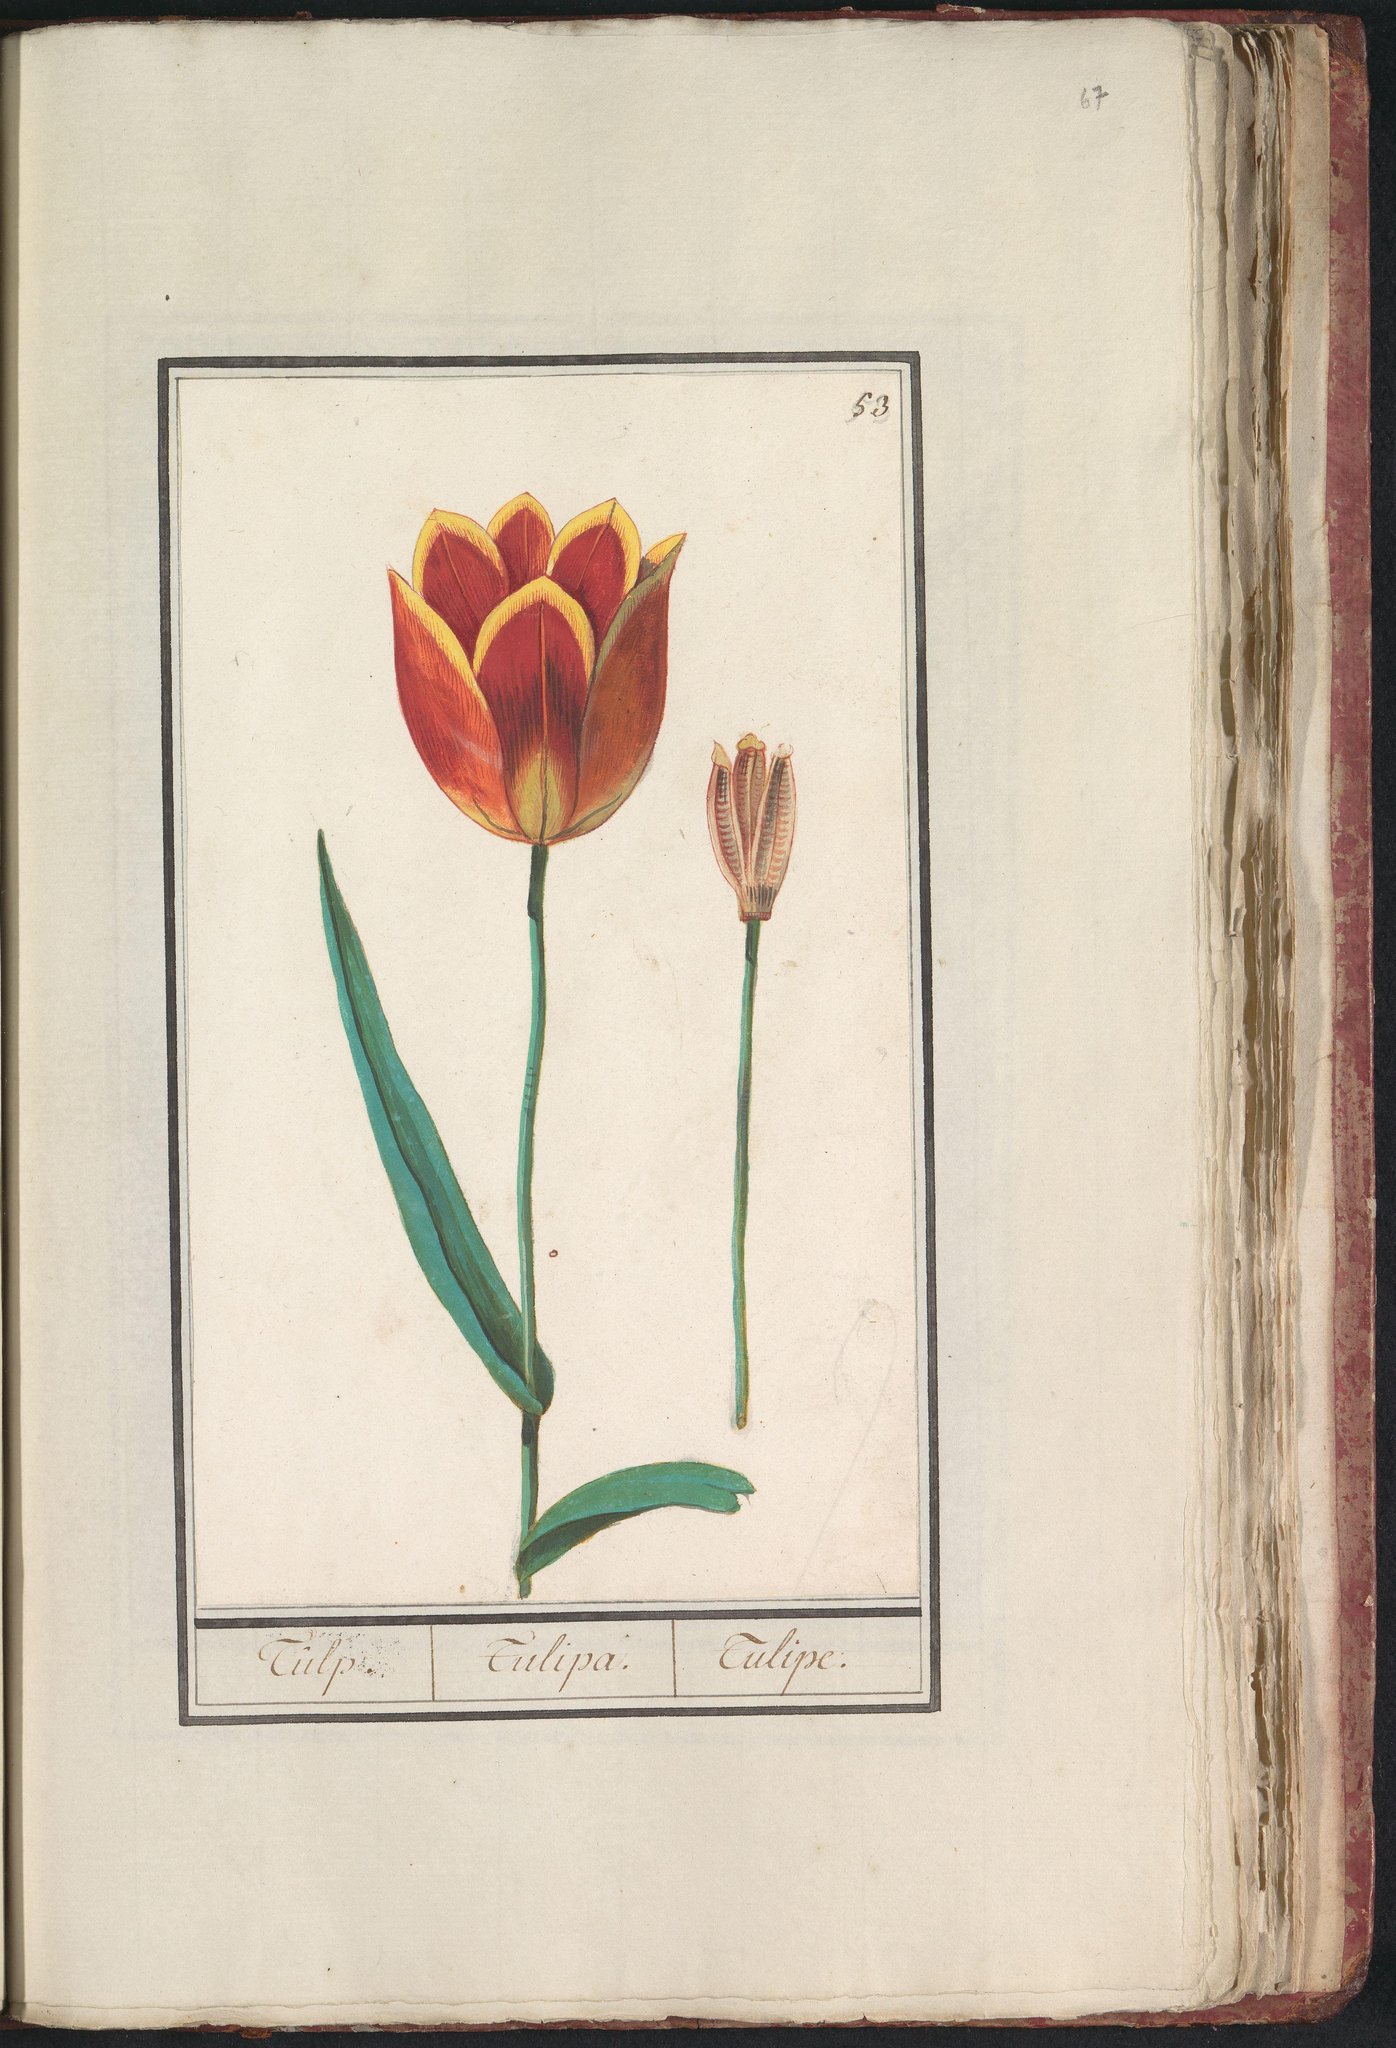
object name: drawing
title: Tulp (Tulipa)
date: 1596-1610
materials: chalk, paint, paper, watercolor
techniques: brush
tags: flowers: tulip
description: Rood-gele tulp en zaaddoos. Genummerd rechtsboven: 53. Onderdeel van het eerste album met tekeningen van bloemen en planten. Achtste van twaalf albums met tekeningen van dieren, vogels en planten bekend rond 1600, gemaakt in opdracht van keizer Rudolf II. Met toelichting in Nederlands, Latijn en Frans.